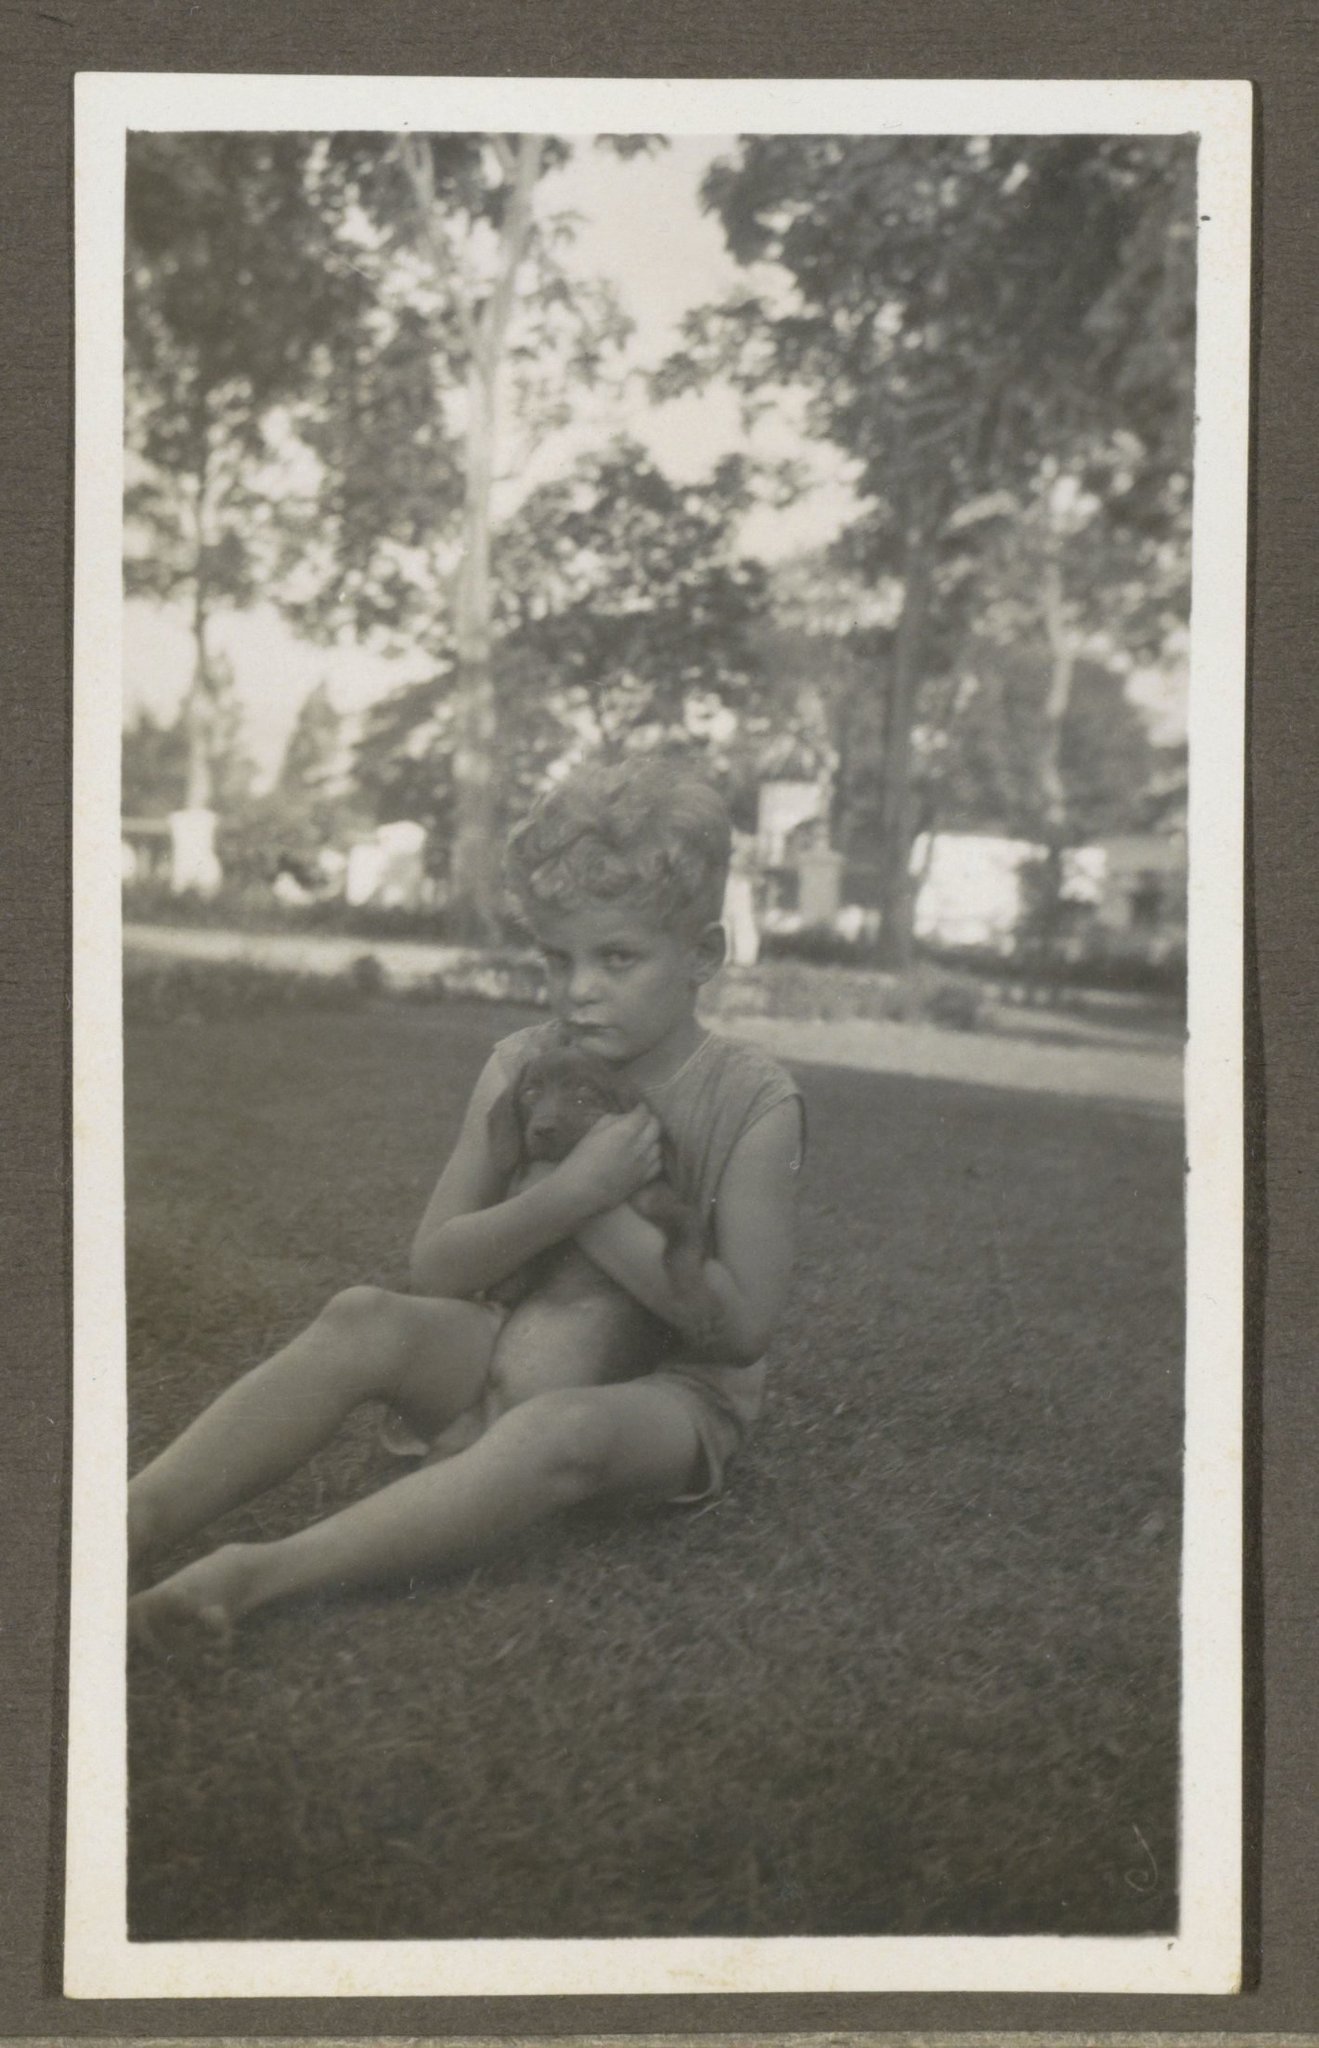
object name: photograph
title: Zittende jongen met een hond in zijn armen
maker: Anonymous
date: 1920-1930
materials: photographic support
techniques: gelatin silver print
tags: friendship between man and animal; caressing, petting, dutch east indies, the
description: Onderdeel van familiealbum Nederlands-Indië.